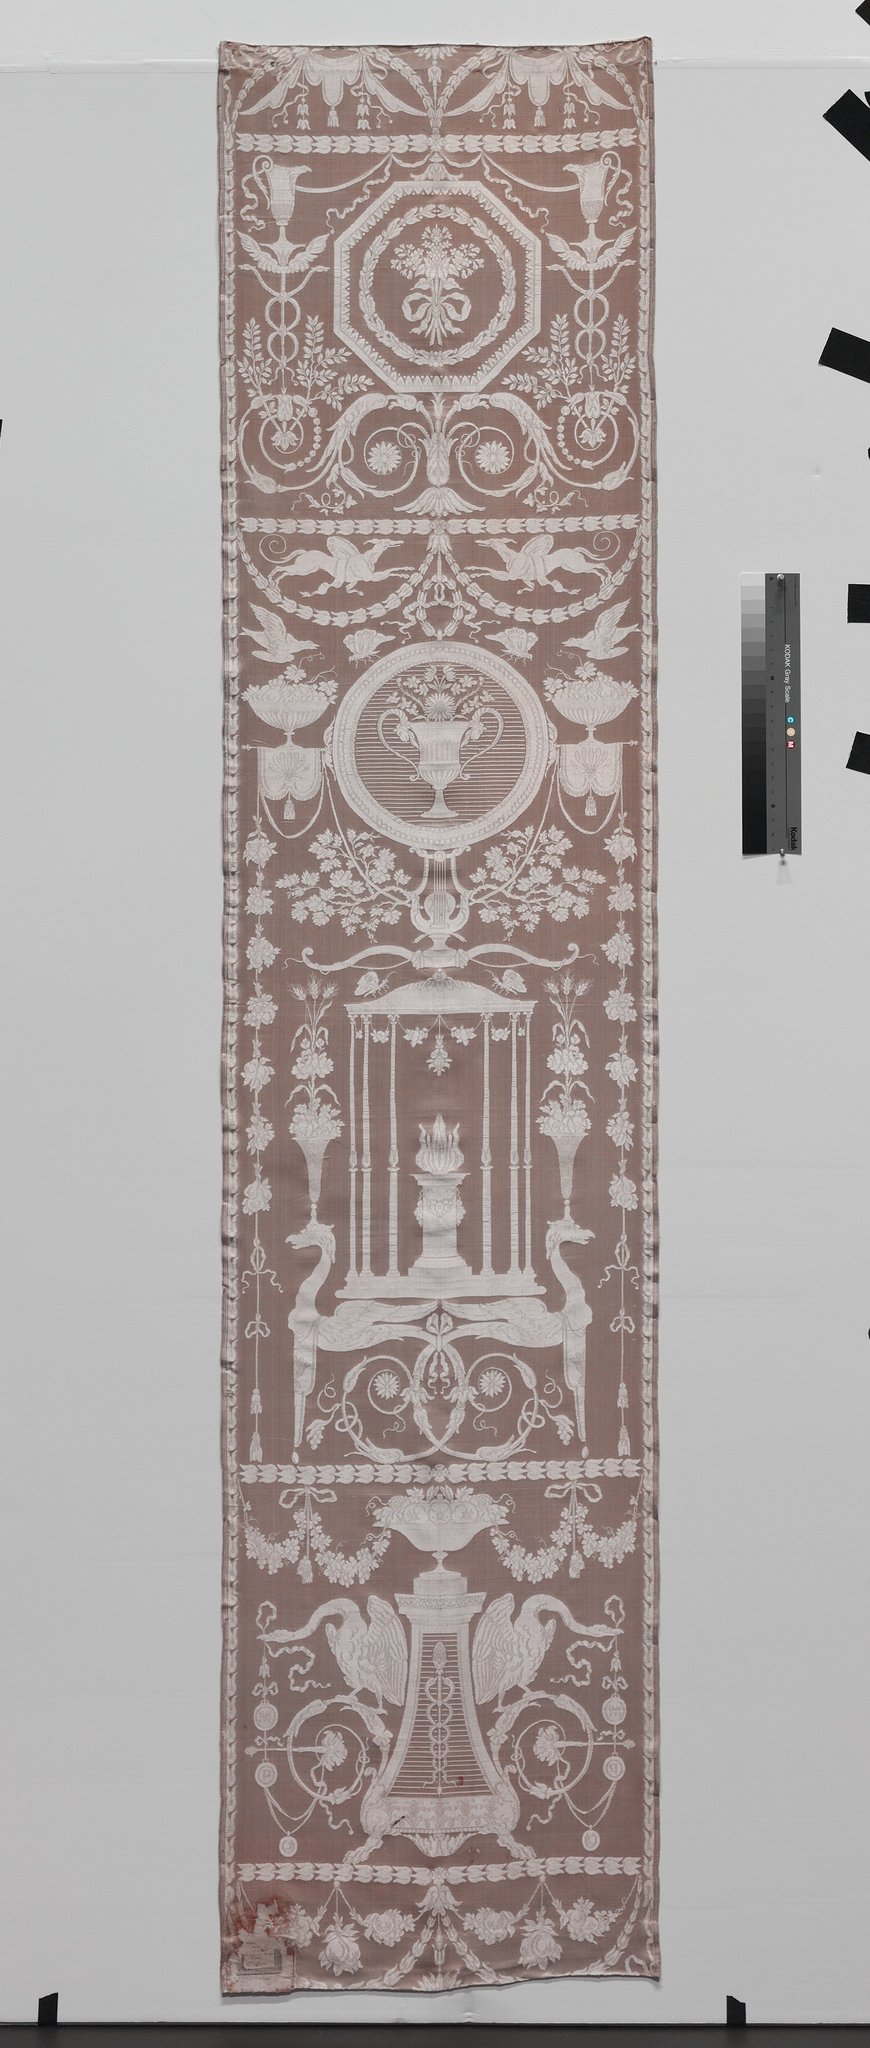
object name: panel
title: L'Autel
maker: jean démosthène dugourc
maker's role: designer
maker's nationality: french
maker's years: 1749-1825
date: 1780-1800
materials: silk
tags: birds,garlands